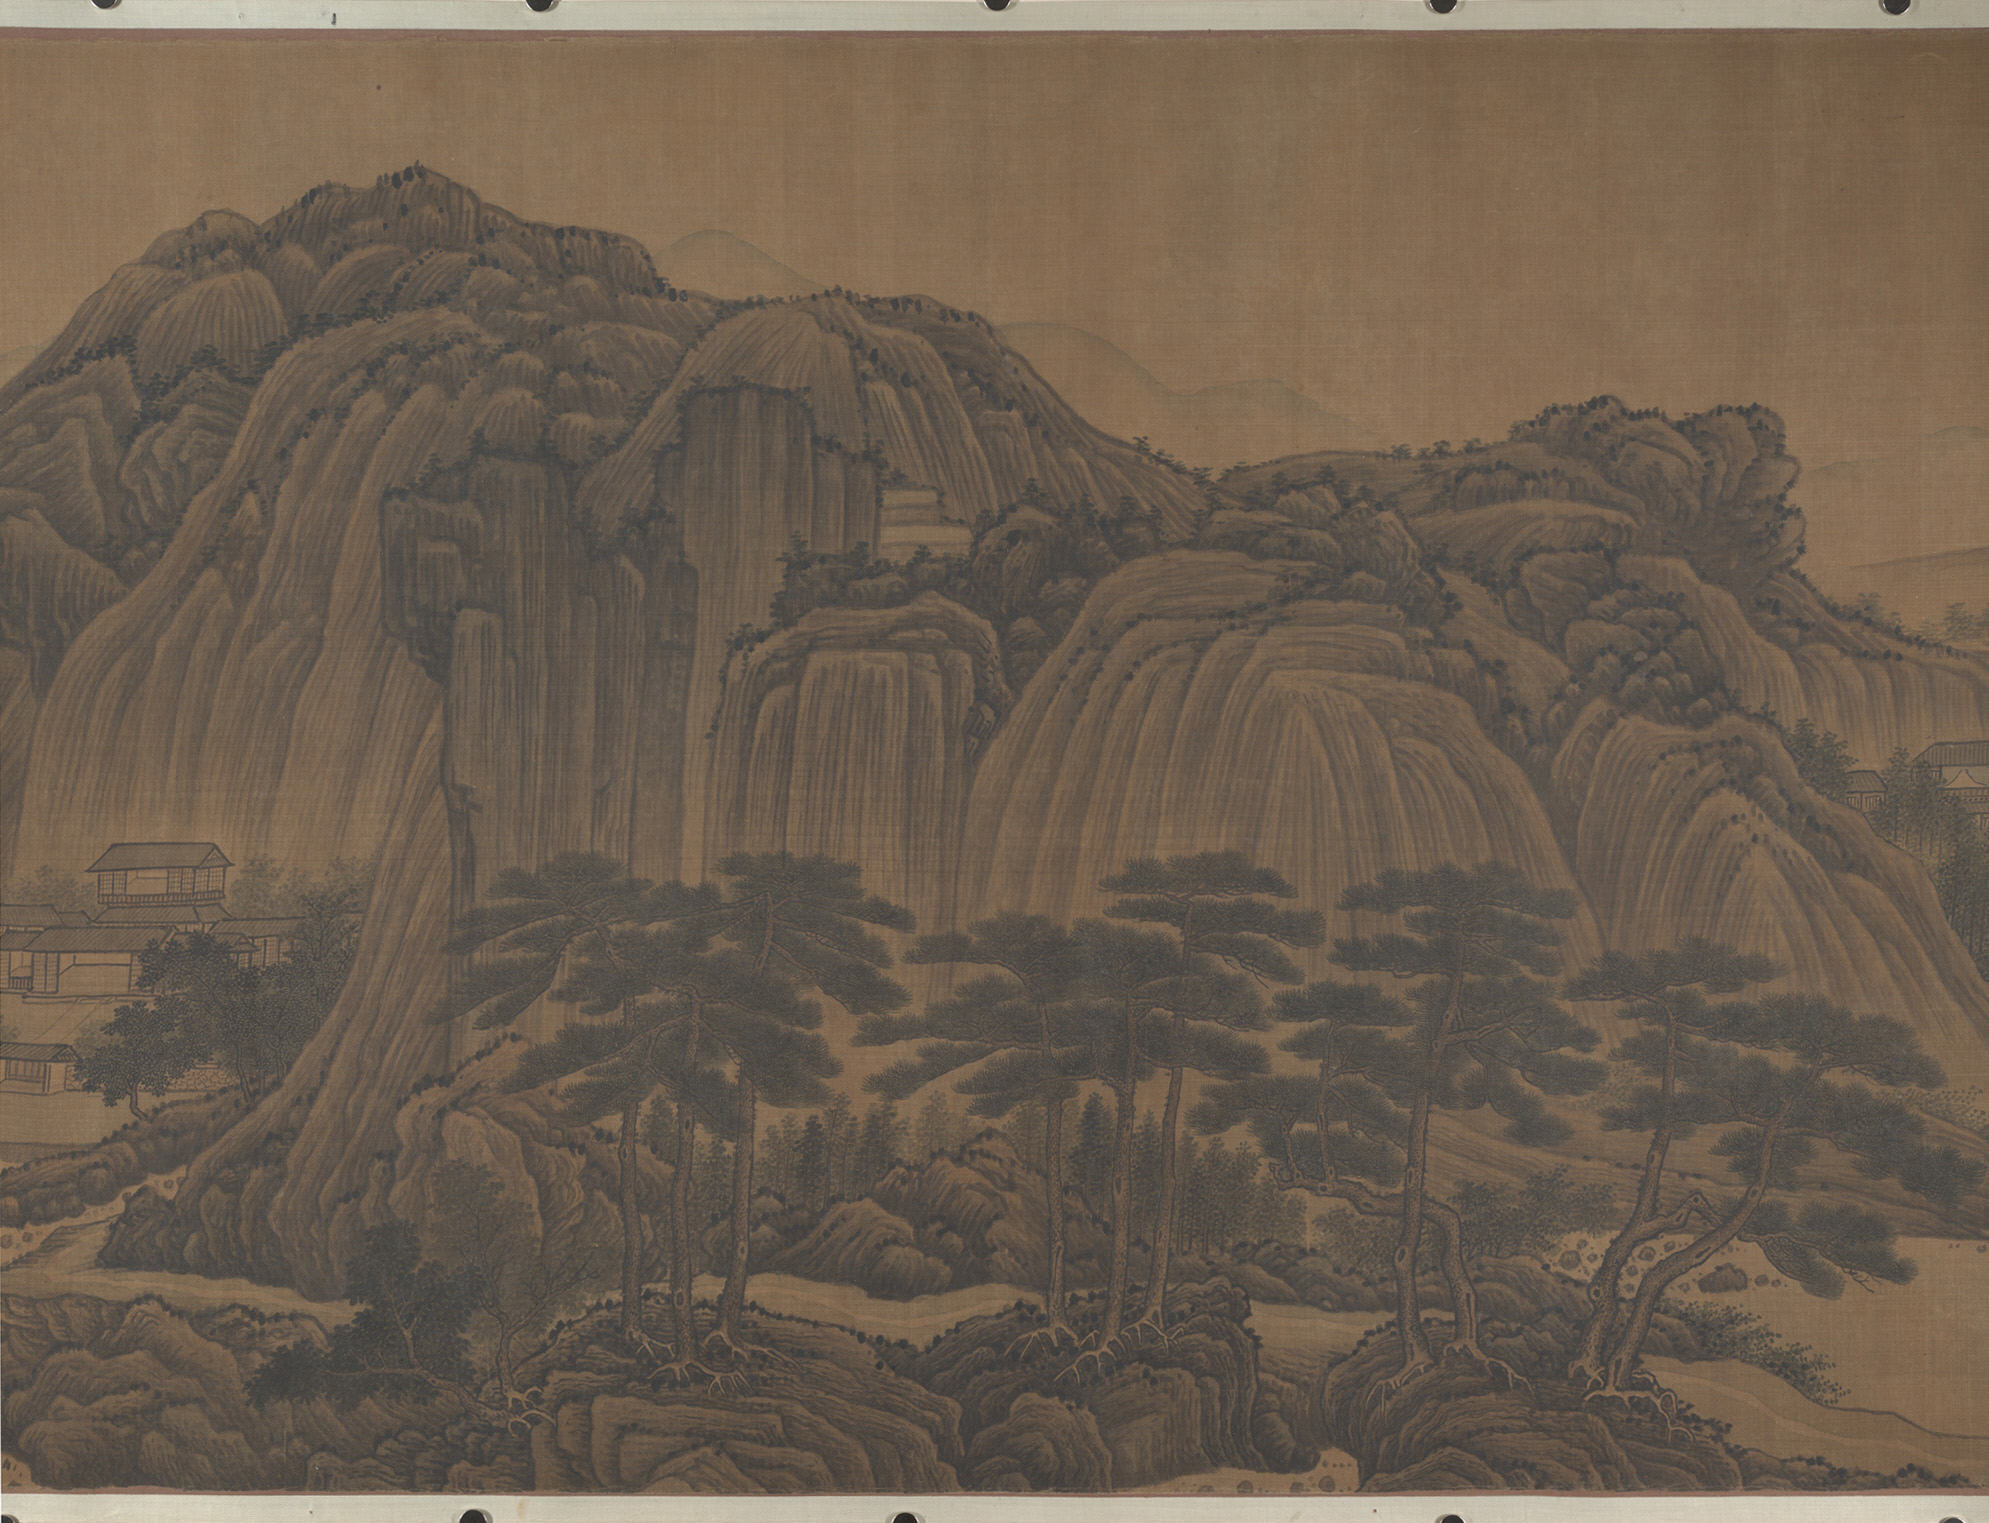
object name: handscroll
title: The Hills of Kuaiji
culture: chinese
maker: unidentified artist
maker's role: artist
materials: ink, silk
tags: hills,landscapes